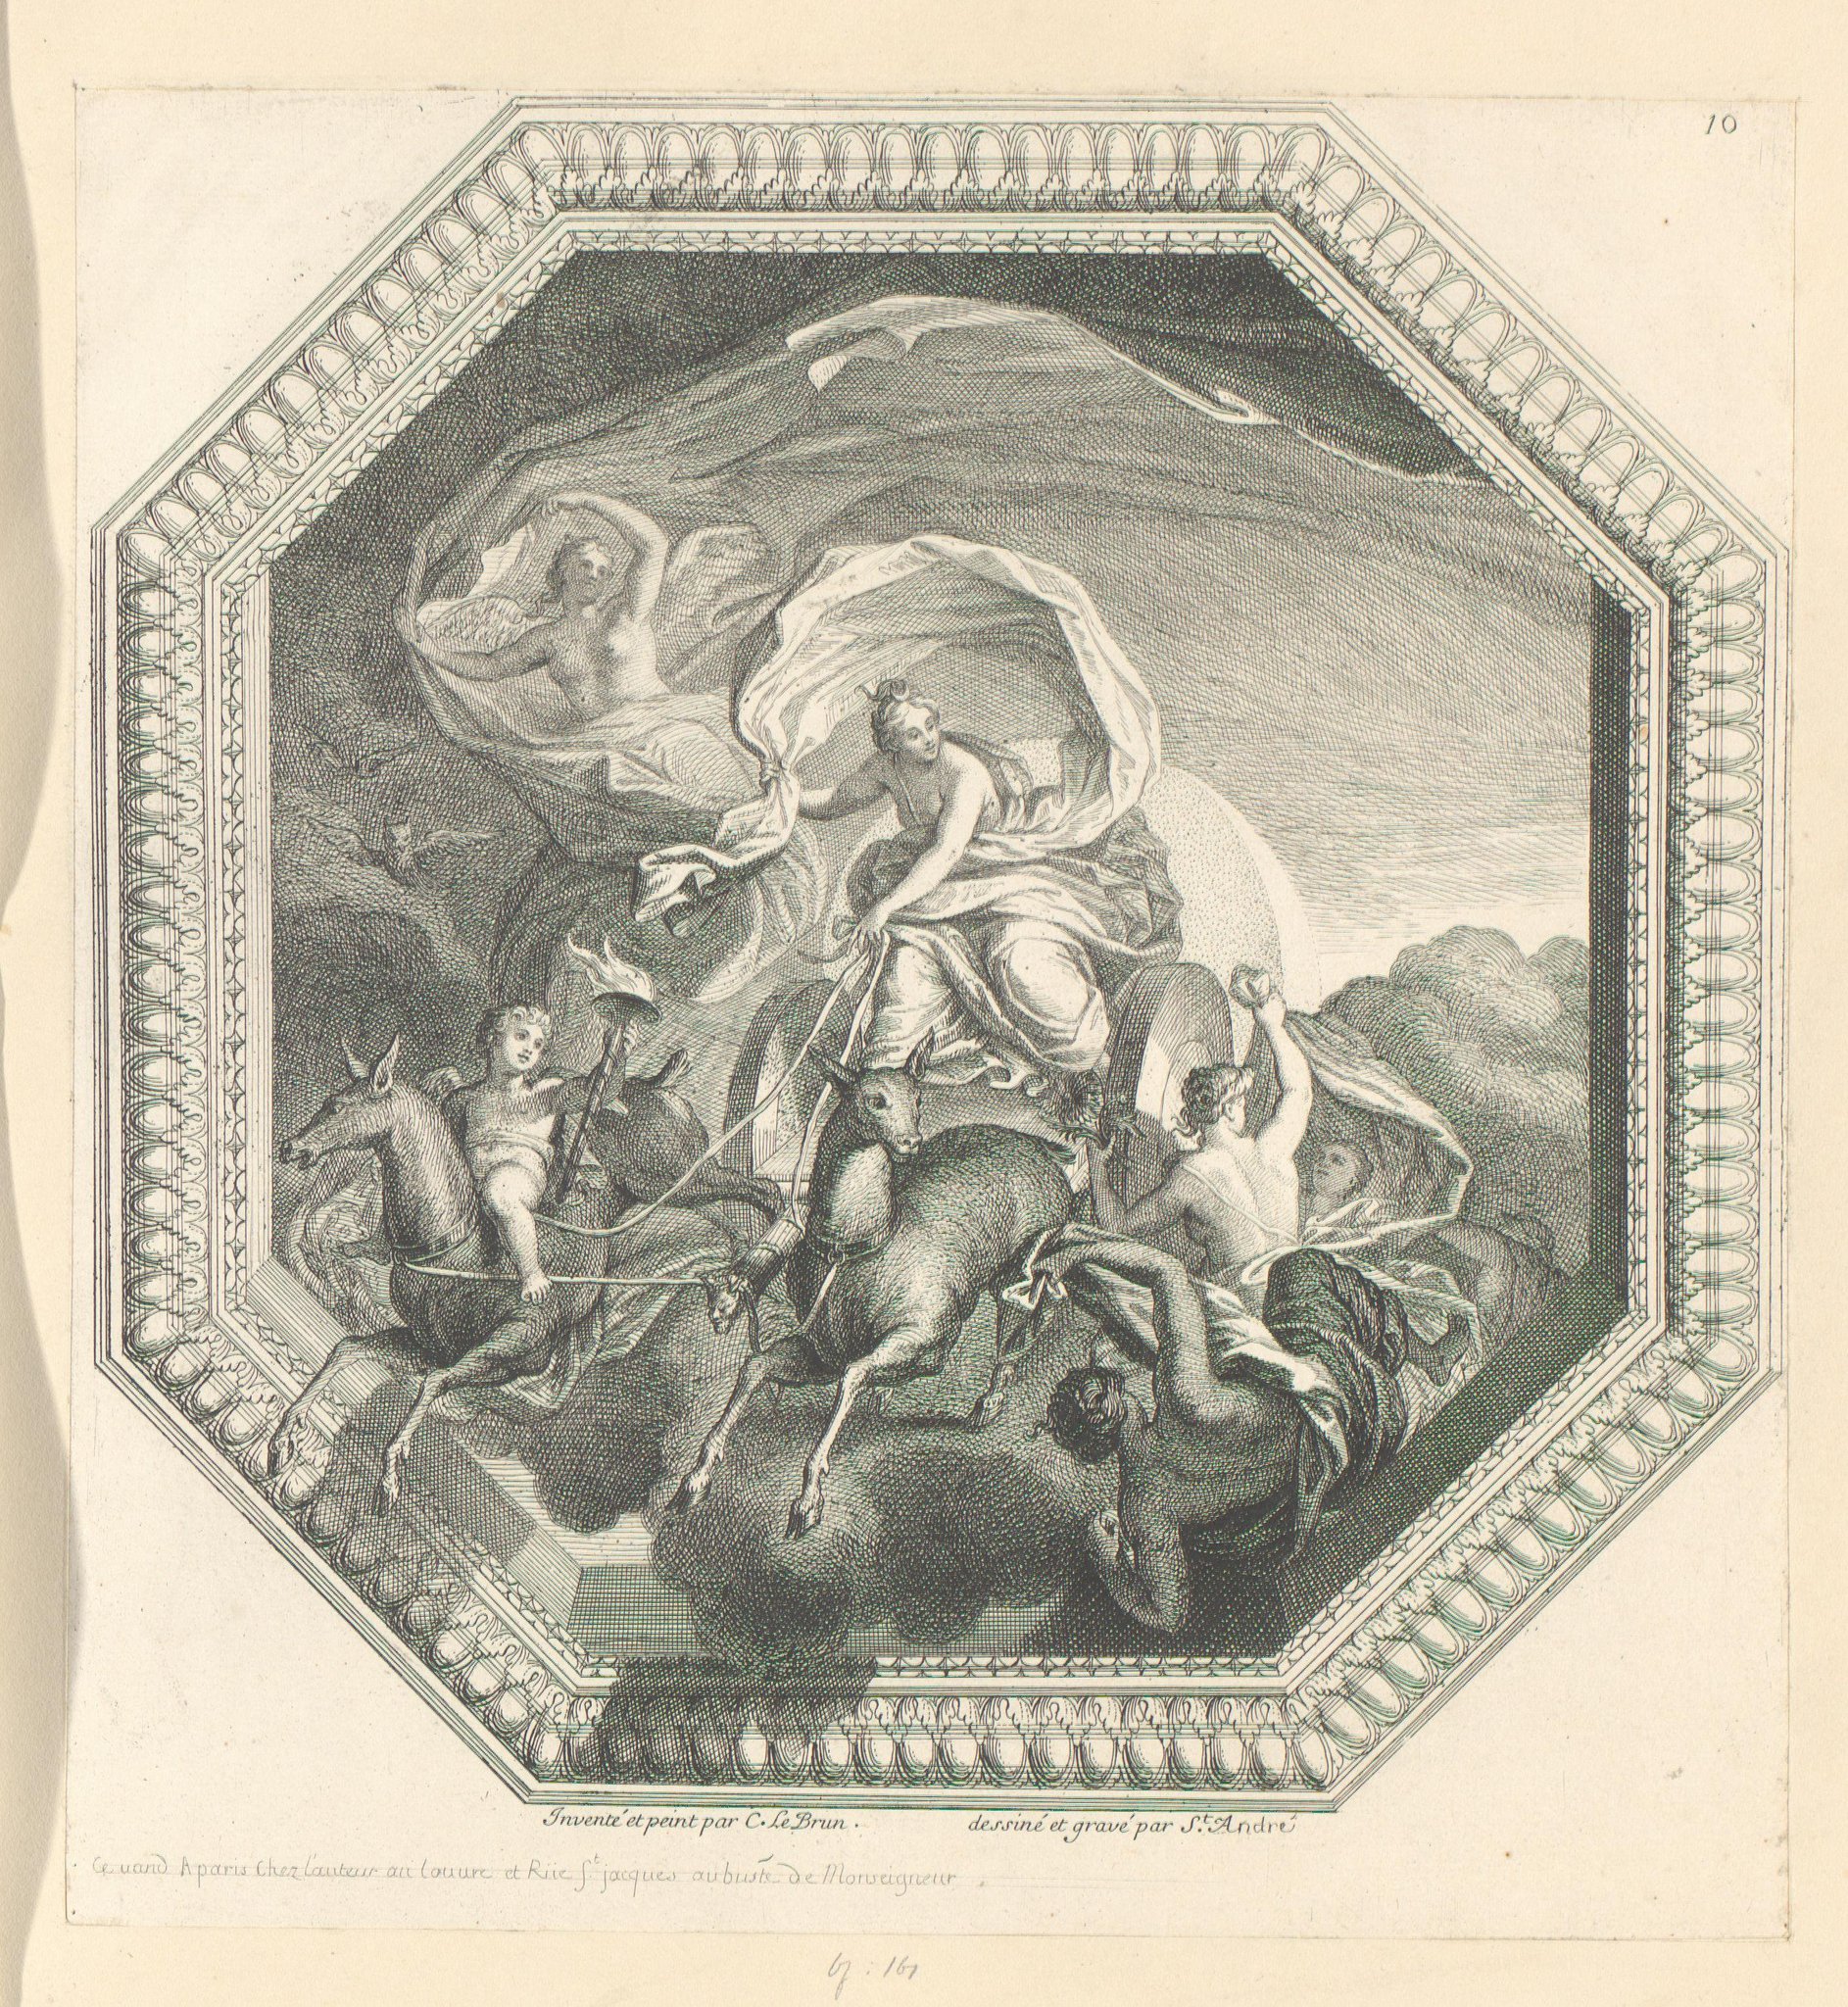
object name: album leaf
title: Plafondschildering uit het Louvre van Diana of de Nacht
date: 1695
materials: paper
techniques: etching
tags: diana as moon-goddess, i.e. luna (selene)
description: Deze prent maakt deel uit van een album.